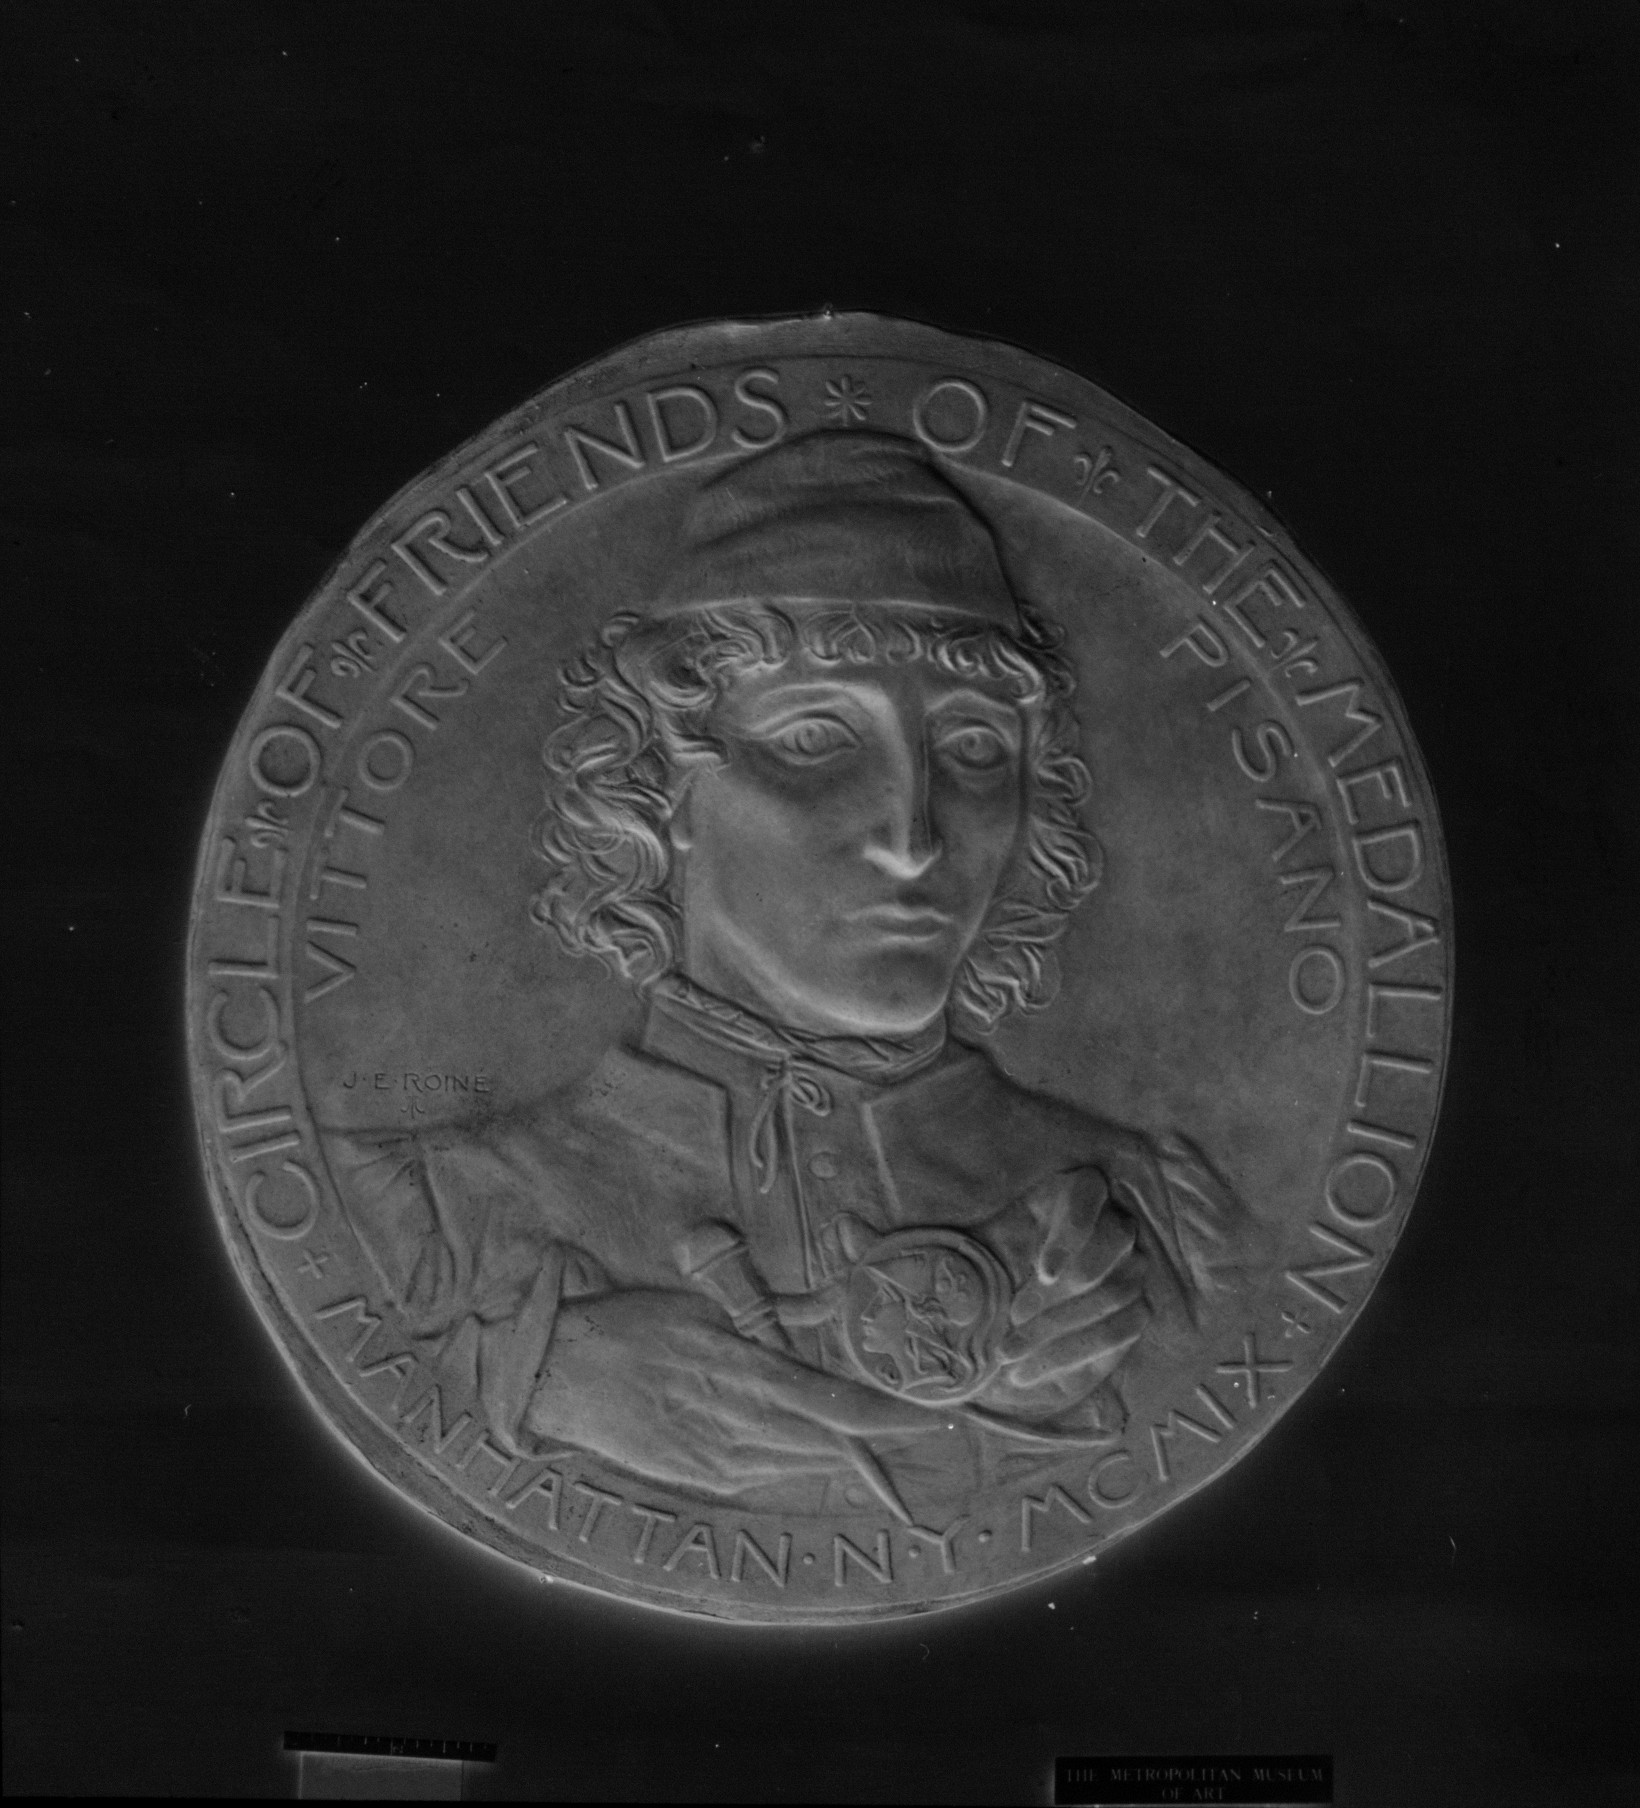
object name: medallion plaque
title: Memorial of Circle of Friends of the Medallion, 1909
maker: jules edouard roiné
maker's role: artist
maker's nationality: french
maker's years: 1857-1916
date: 1909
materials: bronze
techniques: casting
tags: men,portraits